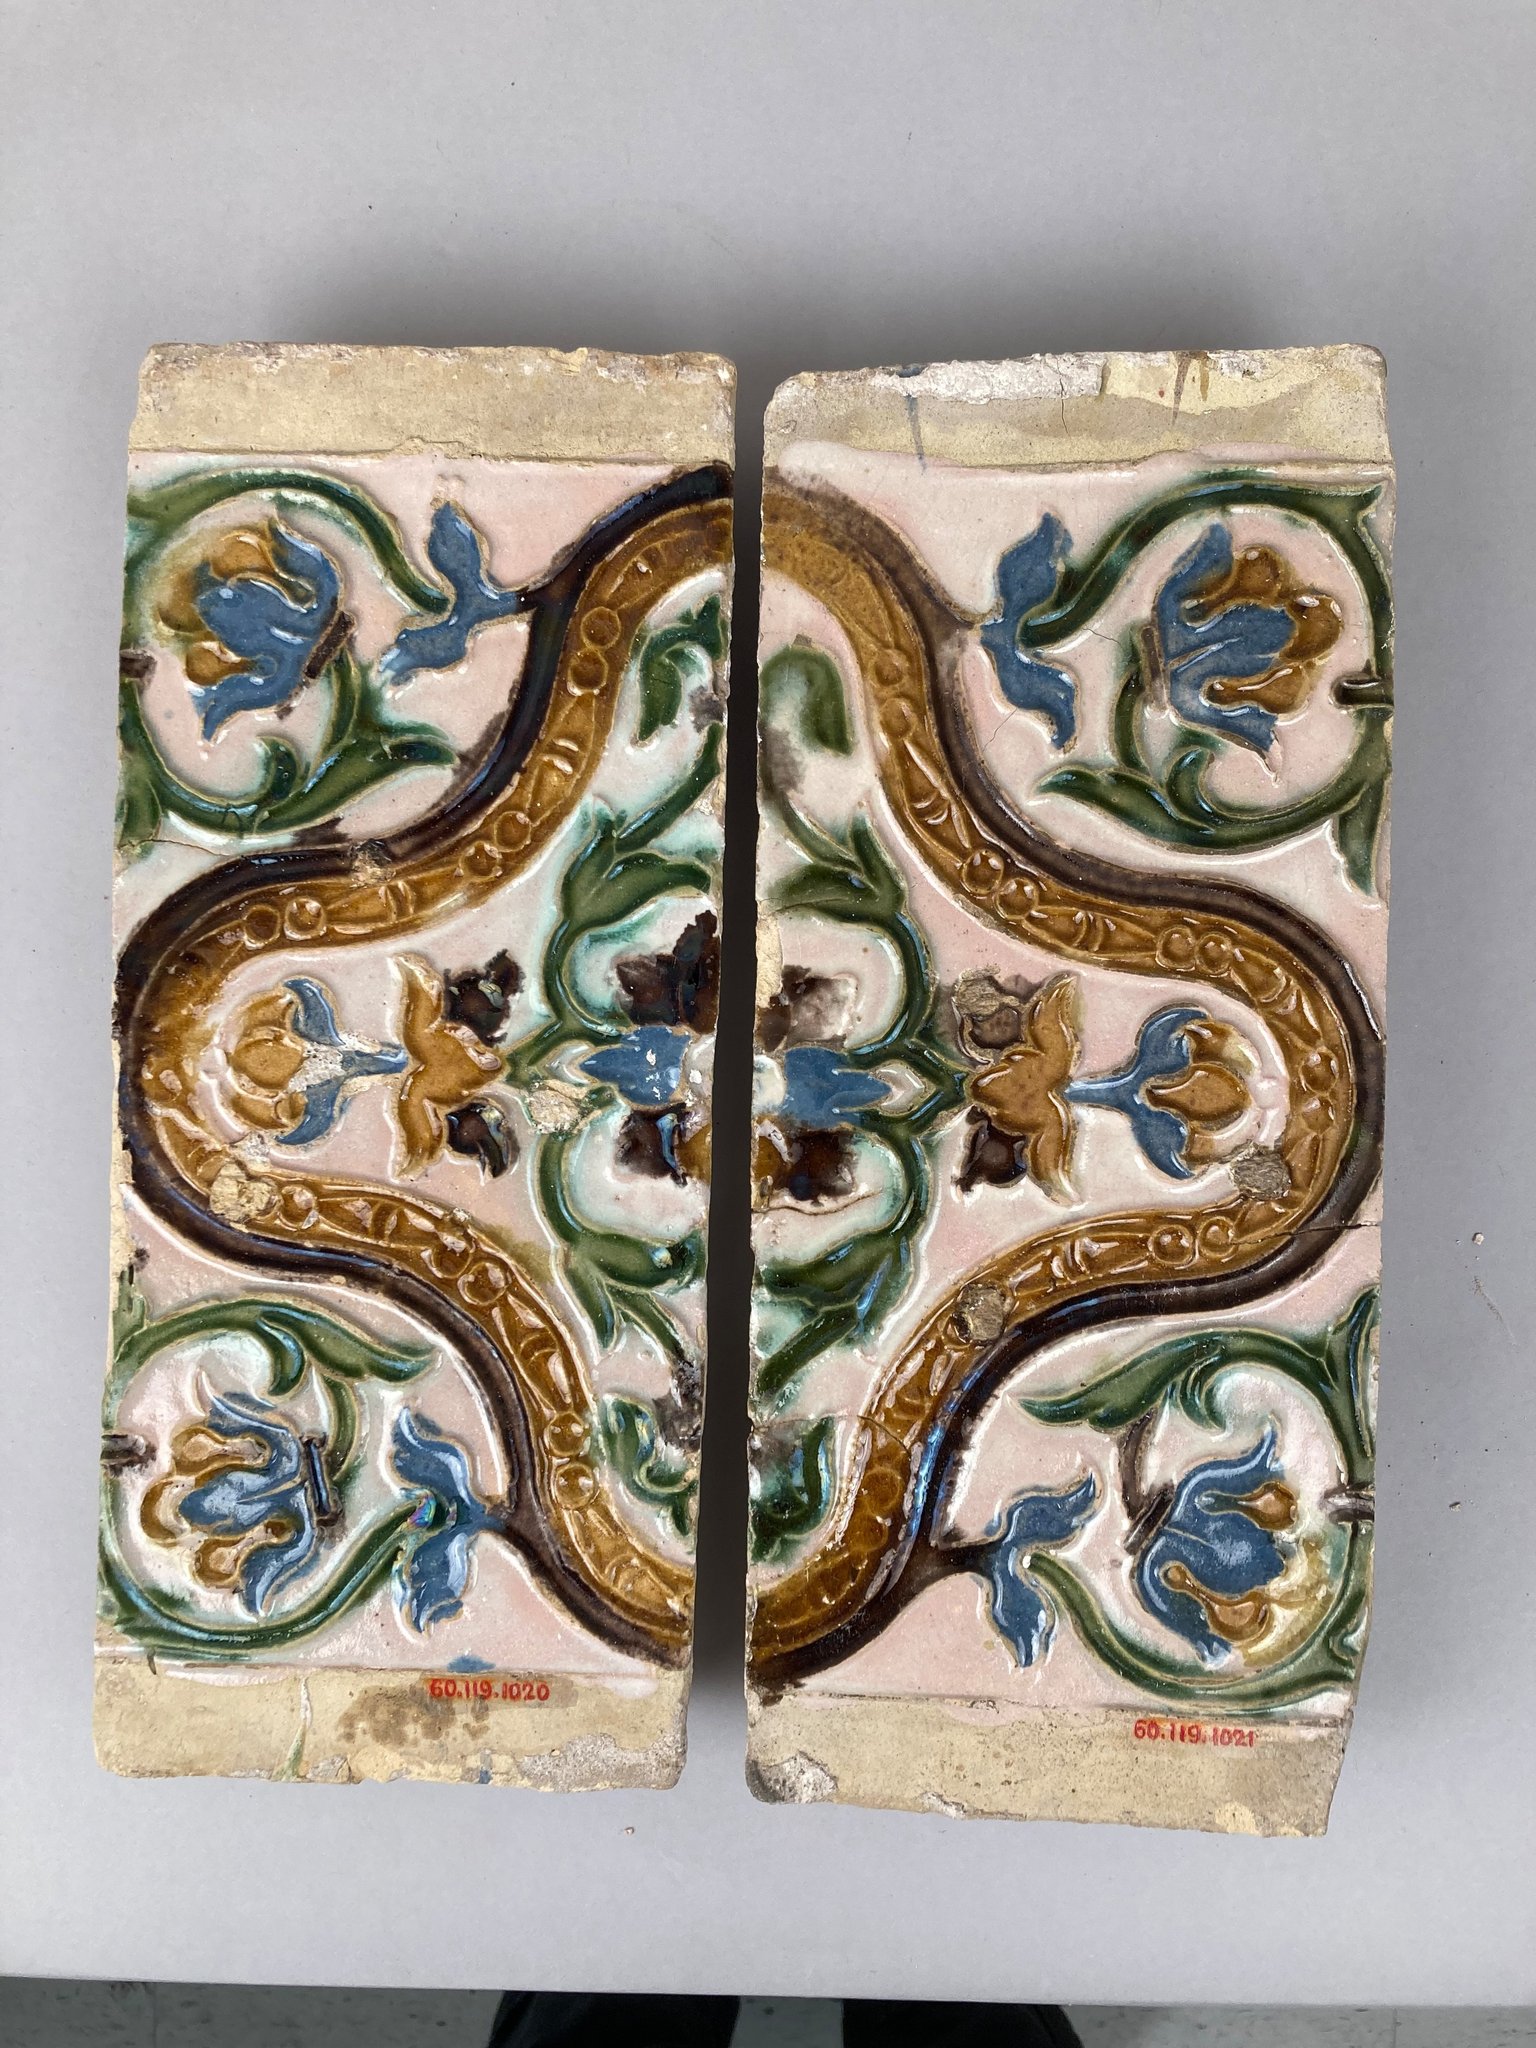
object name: ceiling tile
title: Ceiling tiles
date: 1534-1566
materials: earthenware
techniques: glazing